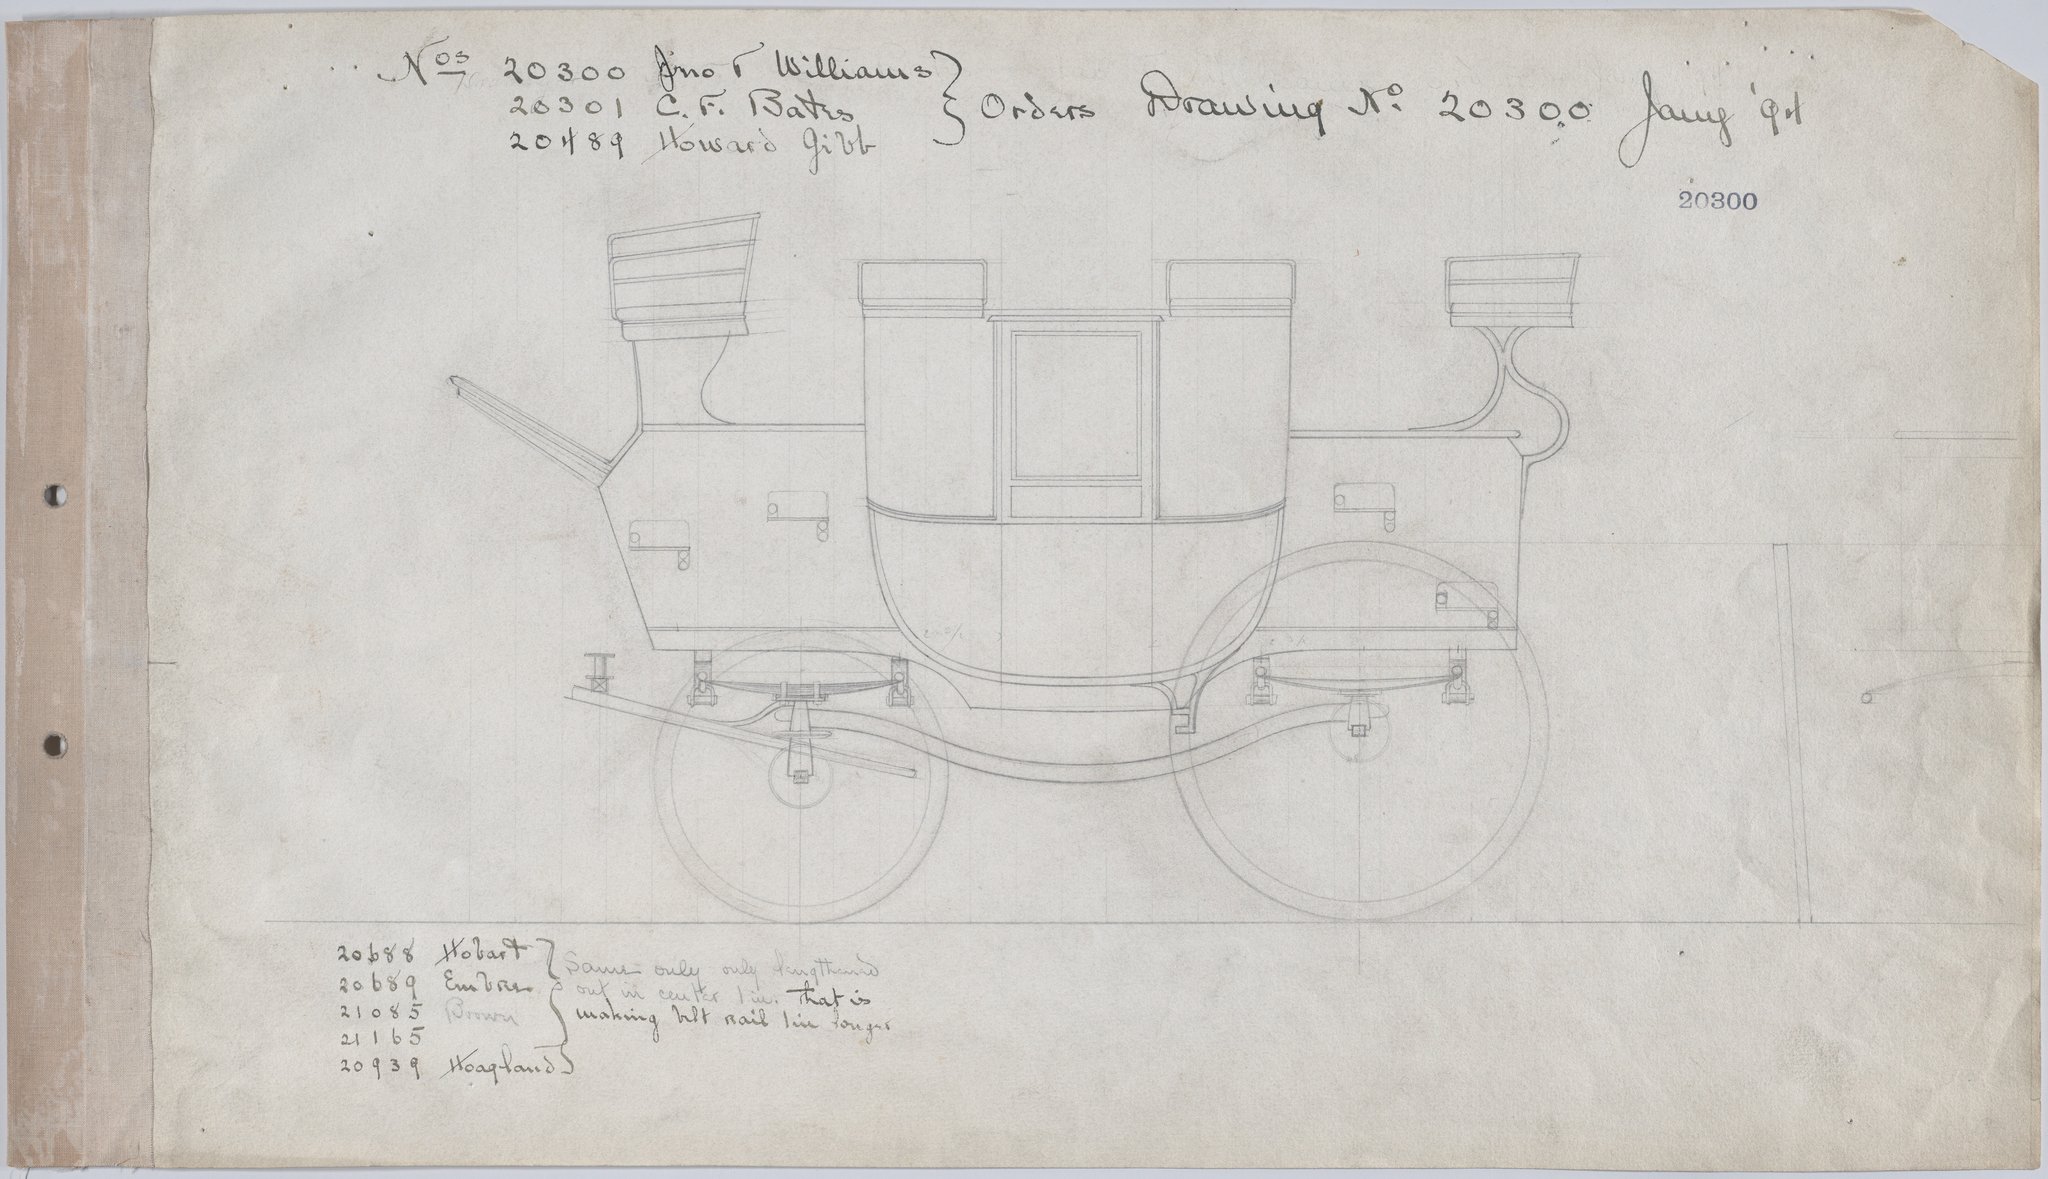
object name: drawing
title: Park Drag #20300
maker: brewster & co.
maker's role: manufacturer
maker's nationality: american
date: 1894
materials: graphite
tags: carriages